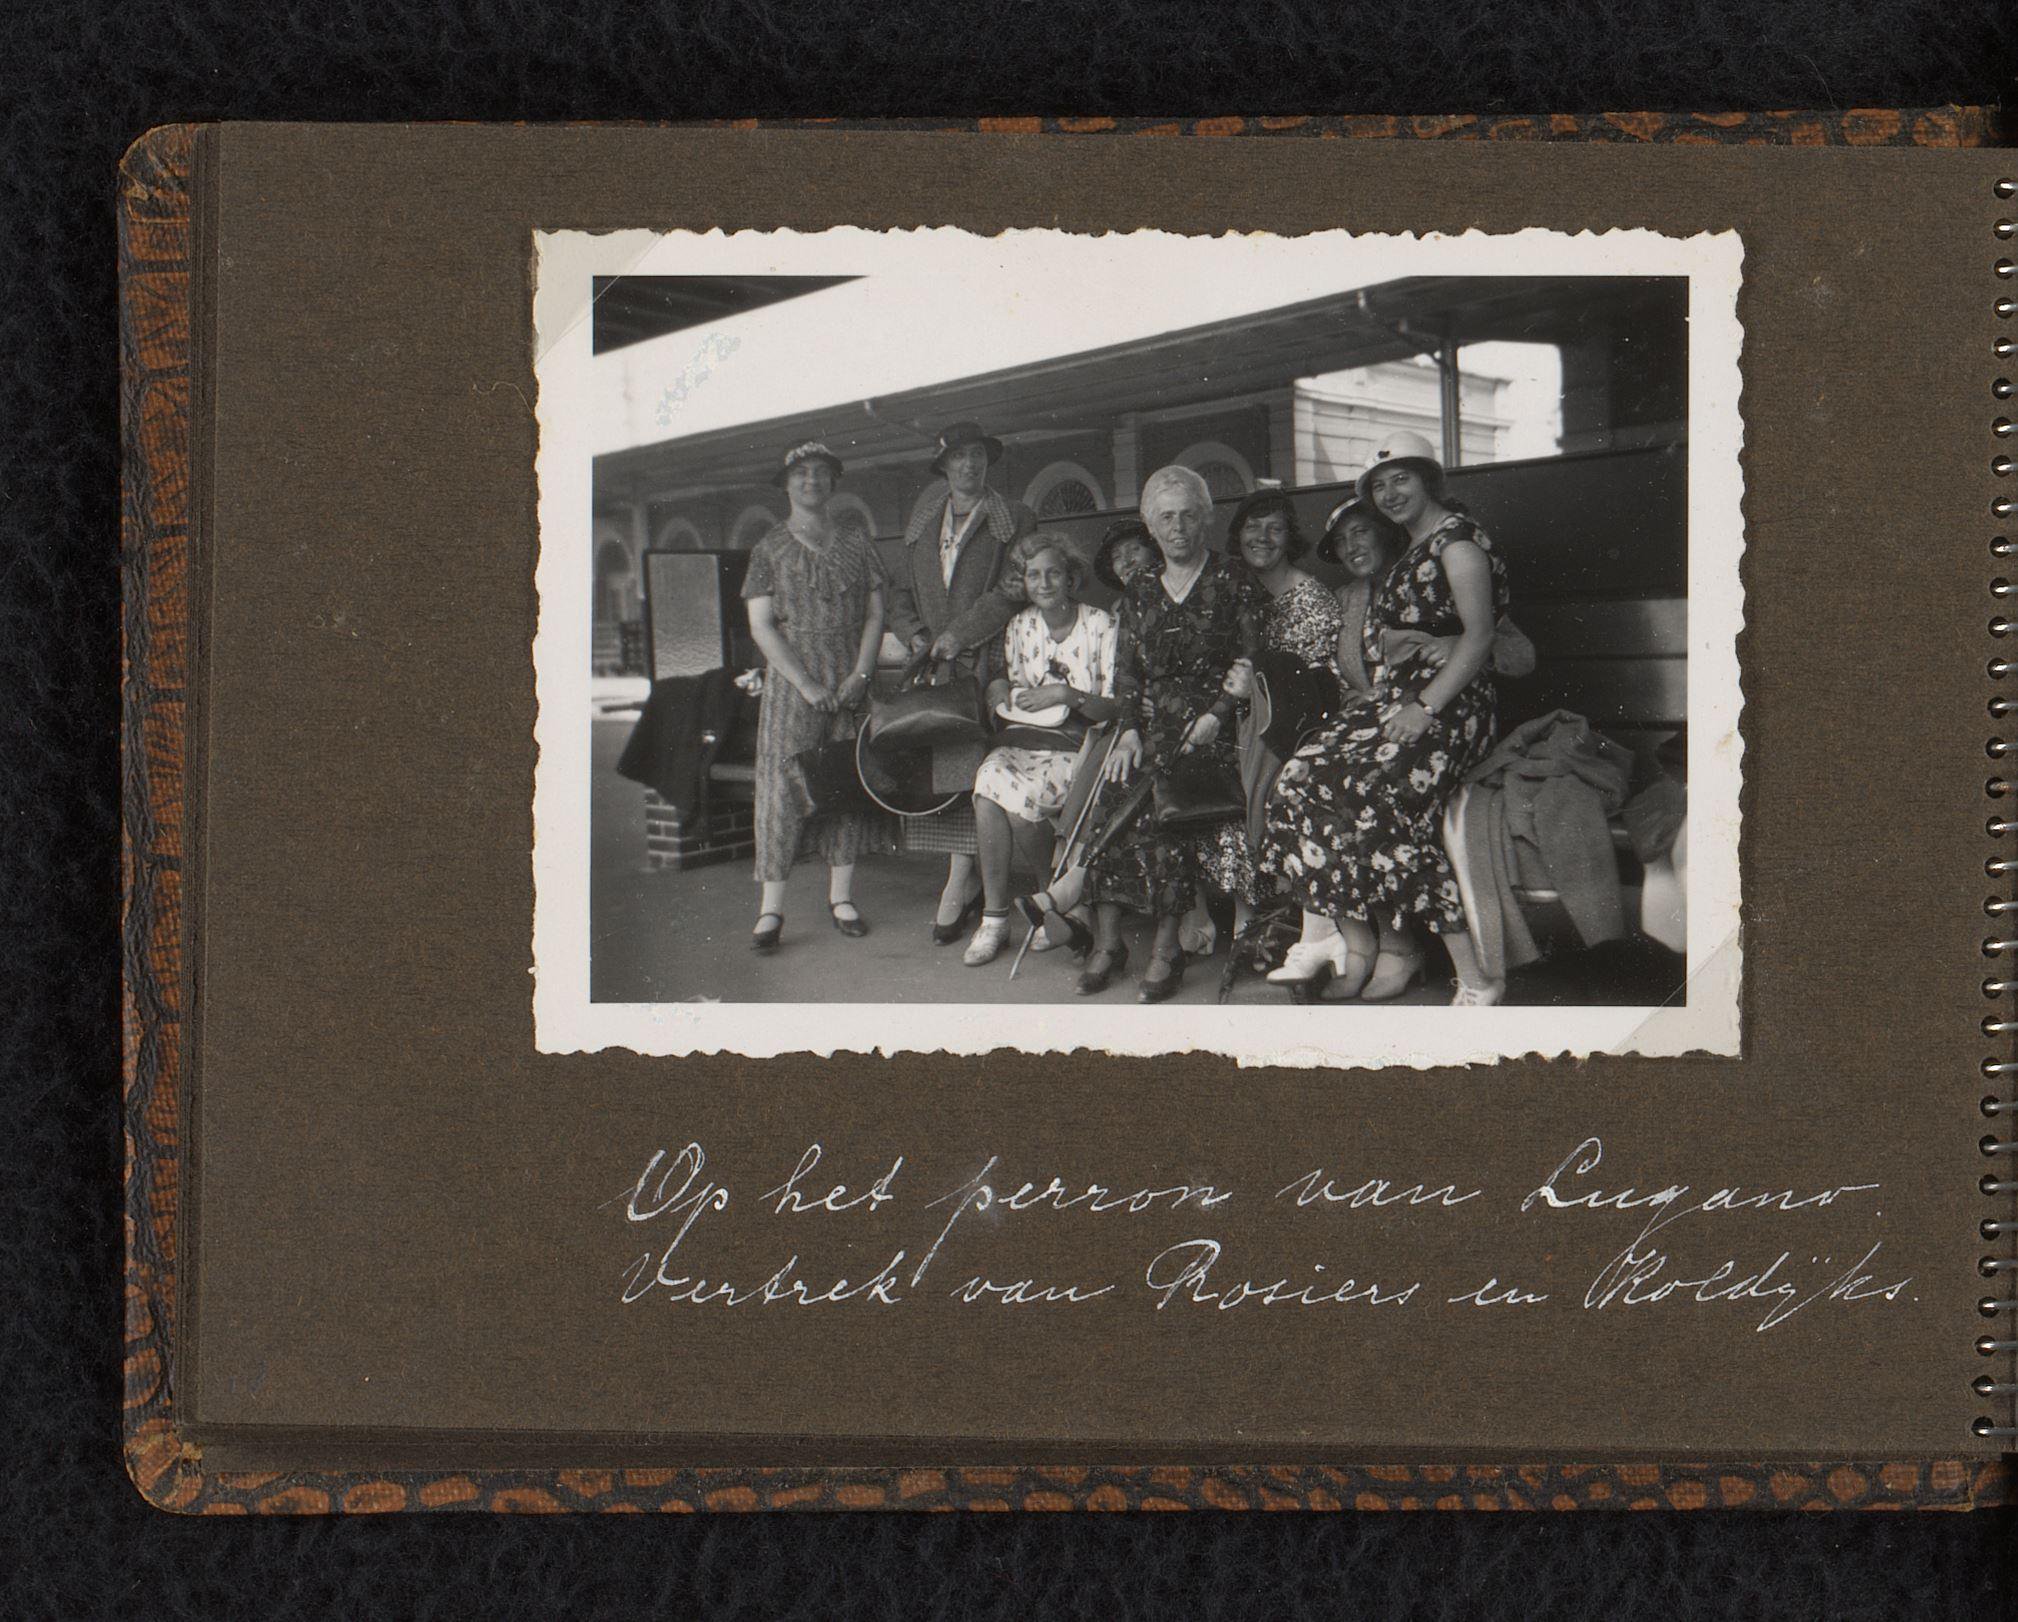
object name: album leaf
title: Groepsportret van een groep vrouwen op het station van Lugano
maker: Anonymous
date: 1908-1934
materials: paper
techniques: gelatin silver print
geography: lugano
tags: platform (railway, tramway), anonymous historical persons portrayed in a group, in a group-portrait